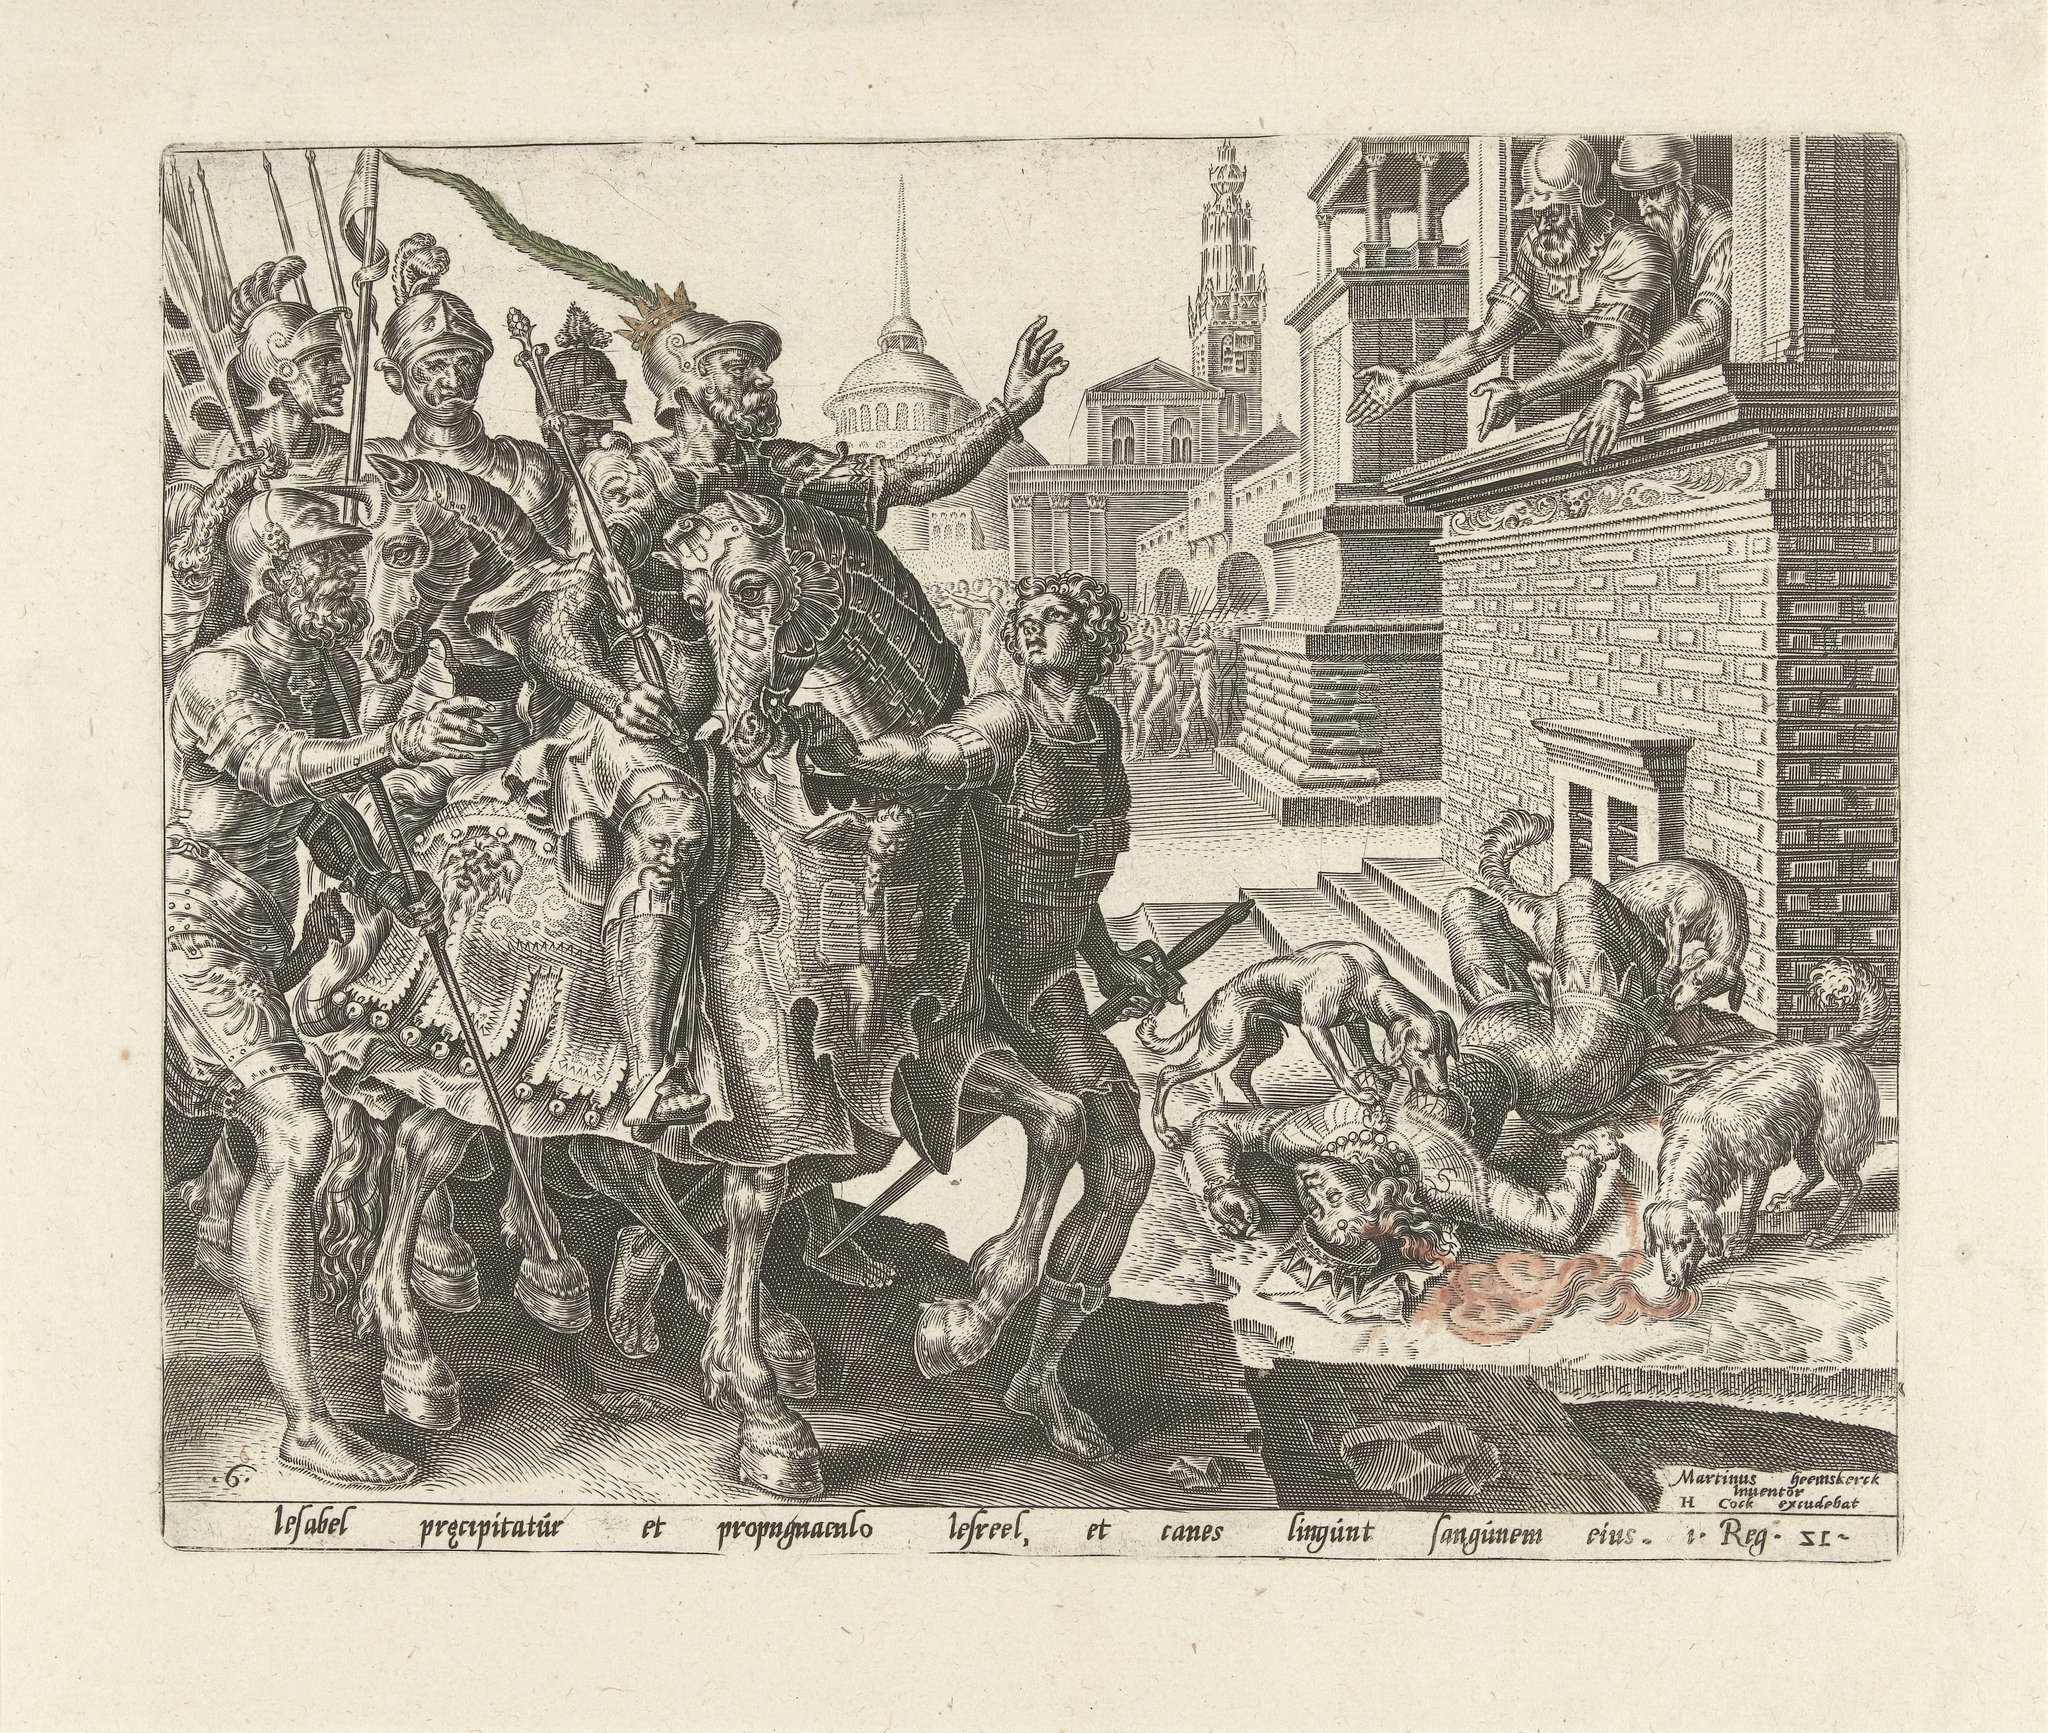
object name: print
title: Geschiedenis van Achab en Nabot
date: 1561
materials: paper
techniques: engraving, hand coloring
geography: haarlem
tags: dogs eat jezebel's body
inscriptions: collector's mark: Lugt 2228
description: Na haar dood wordt Izebels lichaam voor de stadspoorten door de honden opgevreten. Jehu, de nieuwe koning van Israël, kijkt met zijn soldaten naar het tafereel.